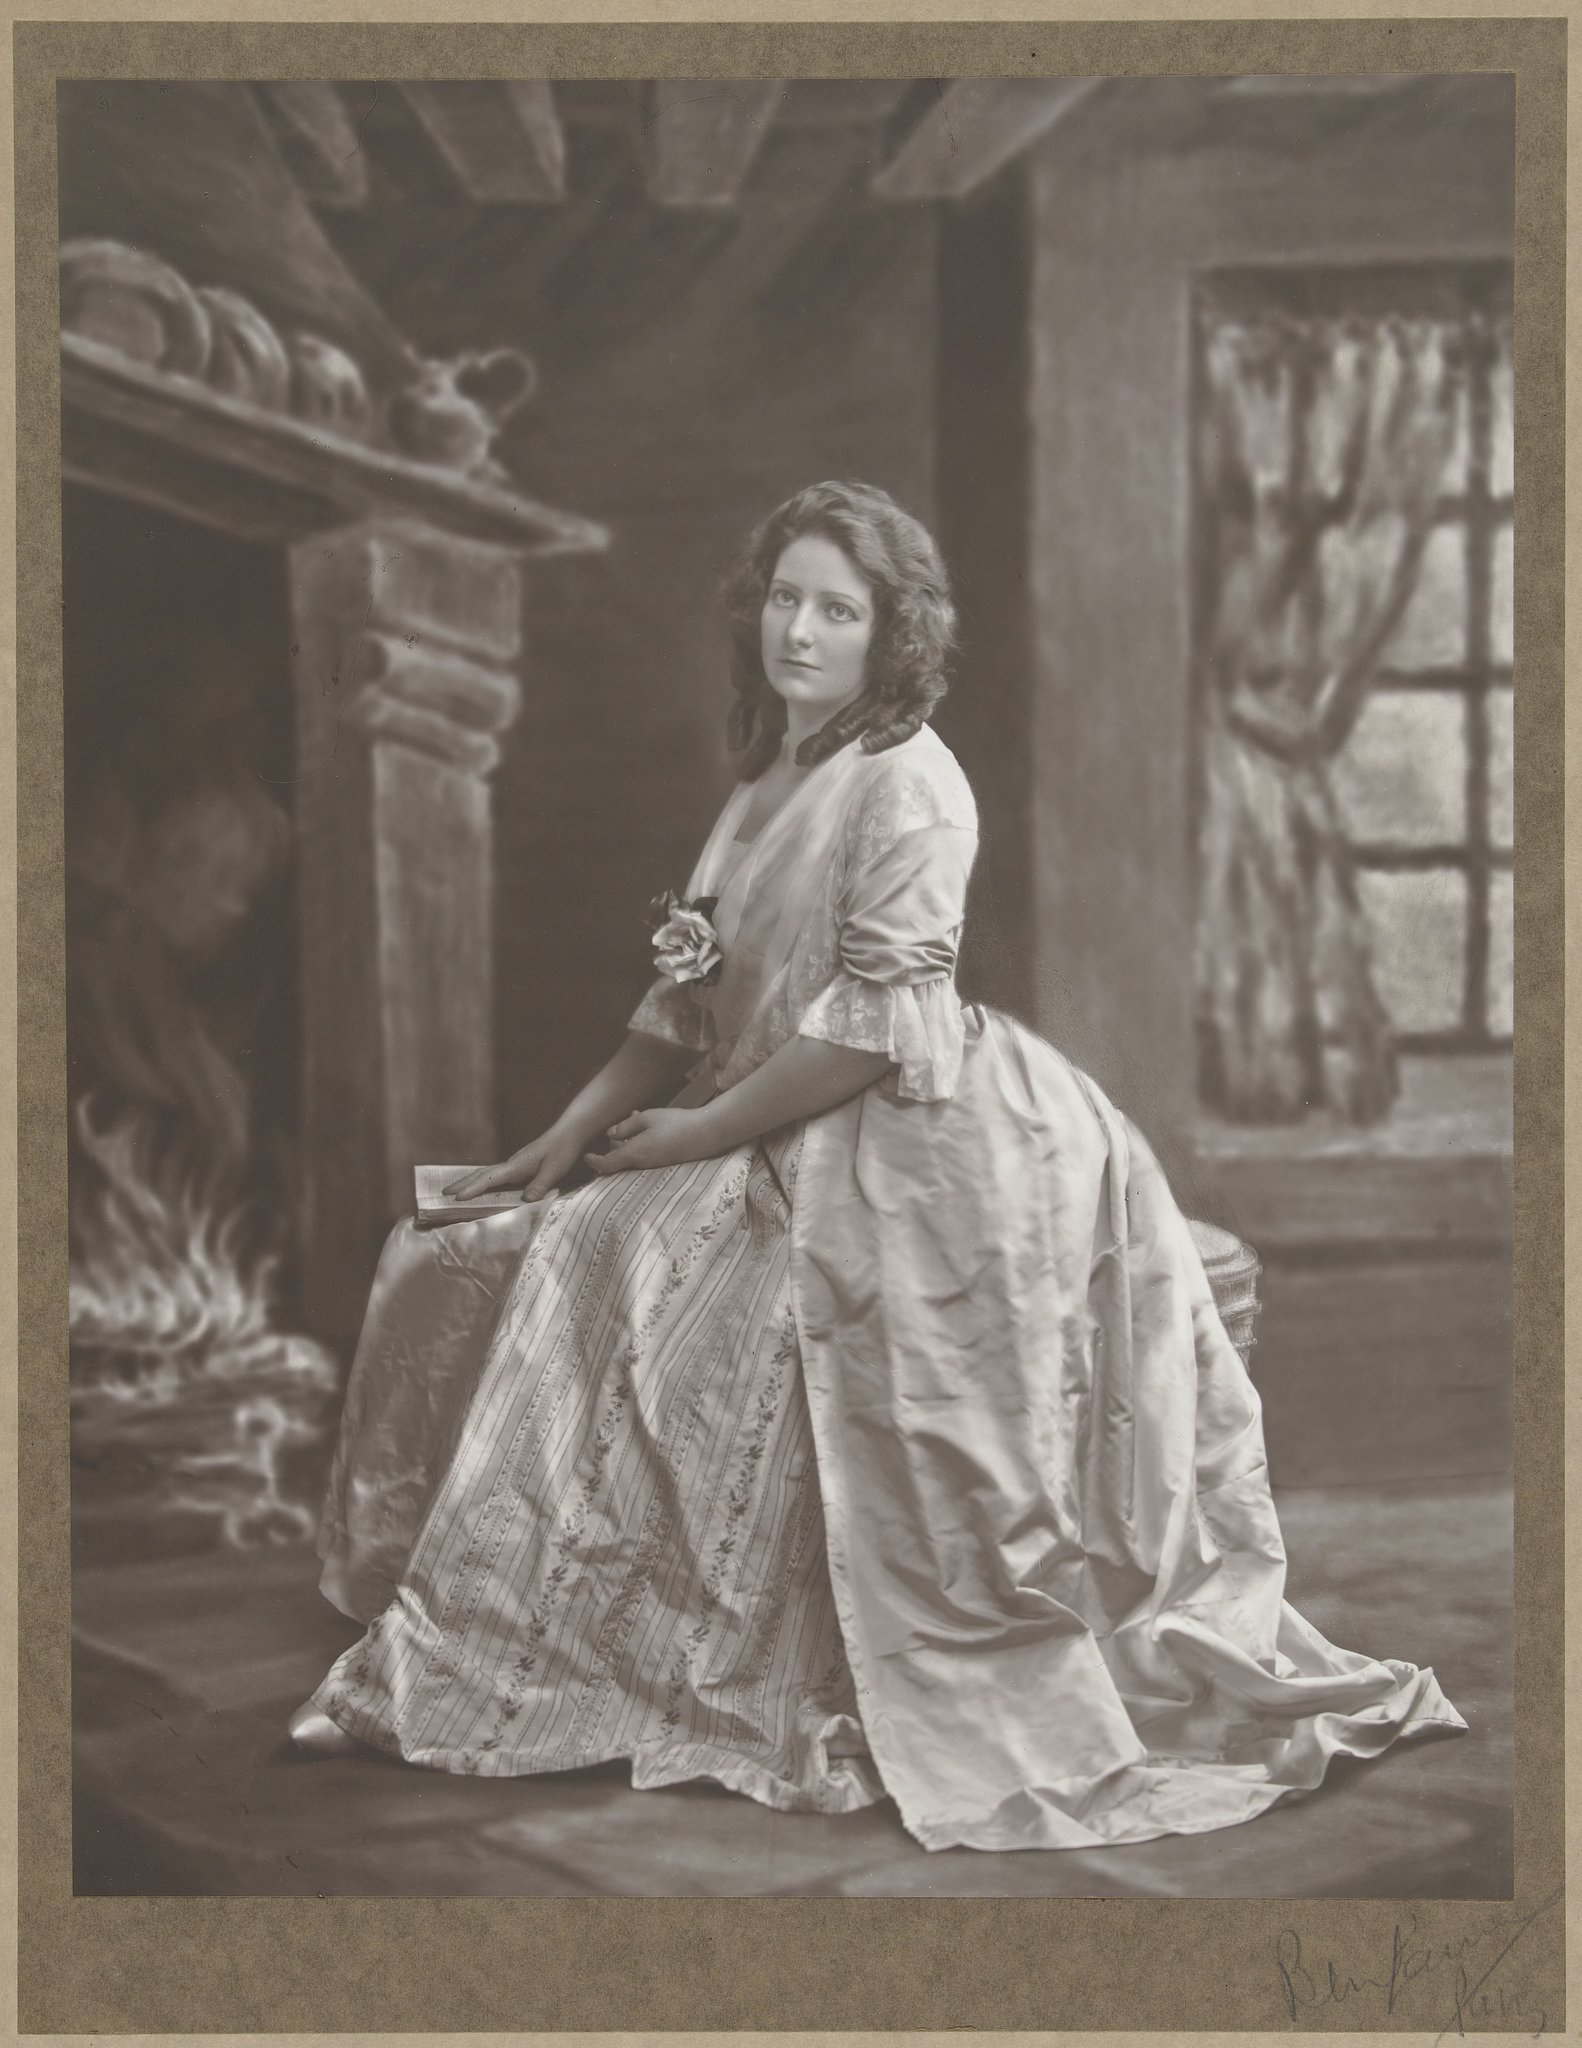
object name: photograph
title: Portret van een onbekende vrouw in een geschilderd decor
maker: benjamin (fotograaf)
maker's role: fotograaf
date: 1900-1925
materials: cardboard, paper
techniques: carbon print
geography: paris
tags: adult woman, anonymous historical person portrayed, paris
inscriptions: inscription: ‘Artist/ proof’, address: ‘Paris/ 15, Rue St. Florentin’